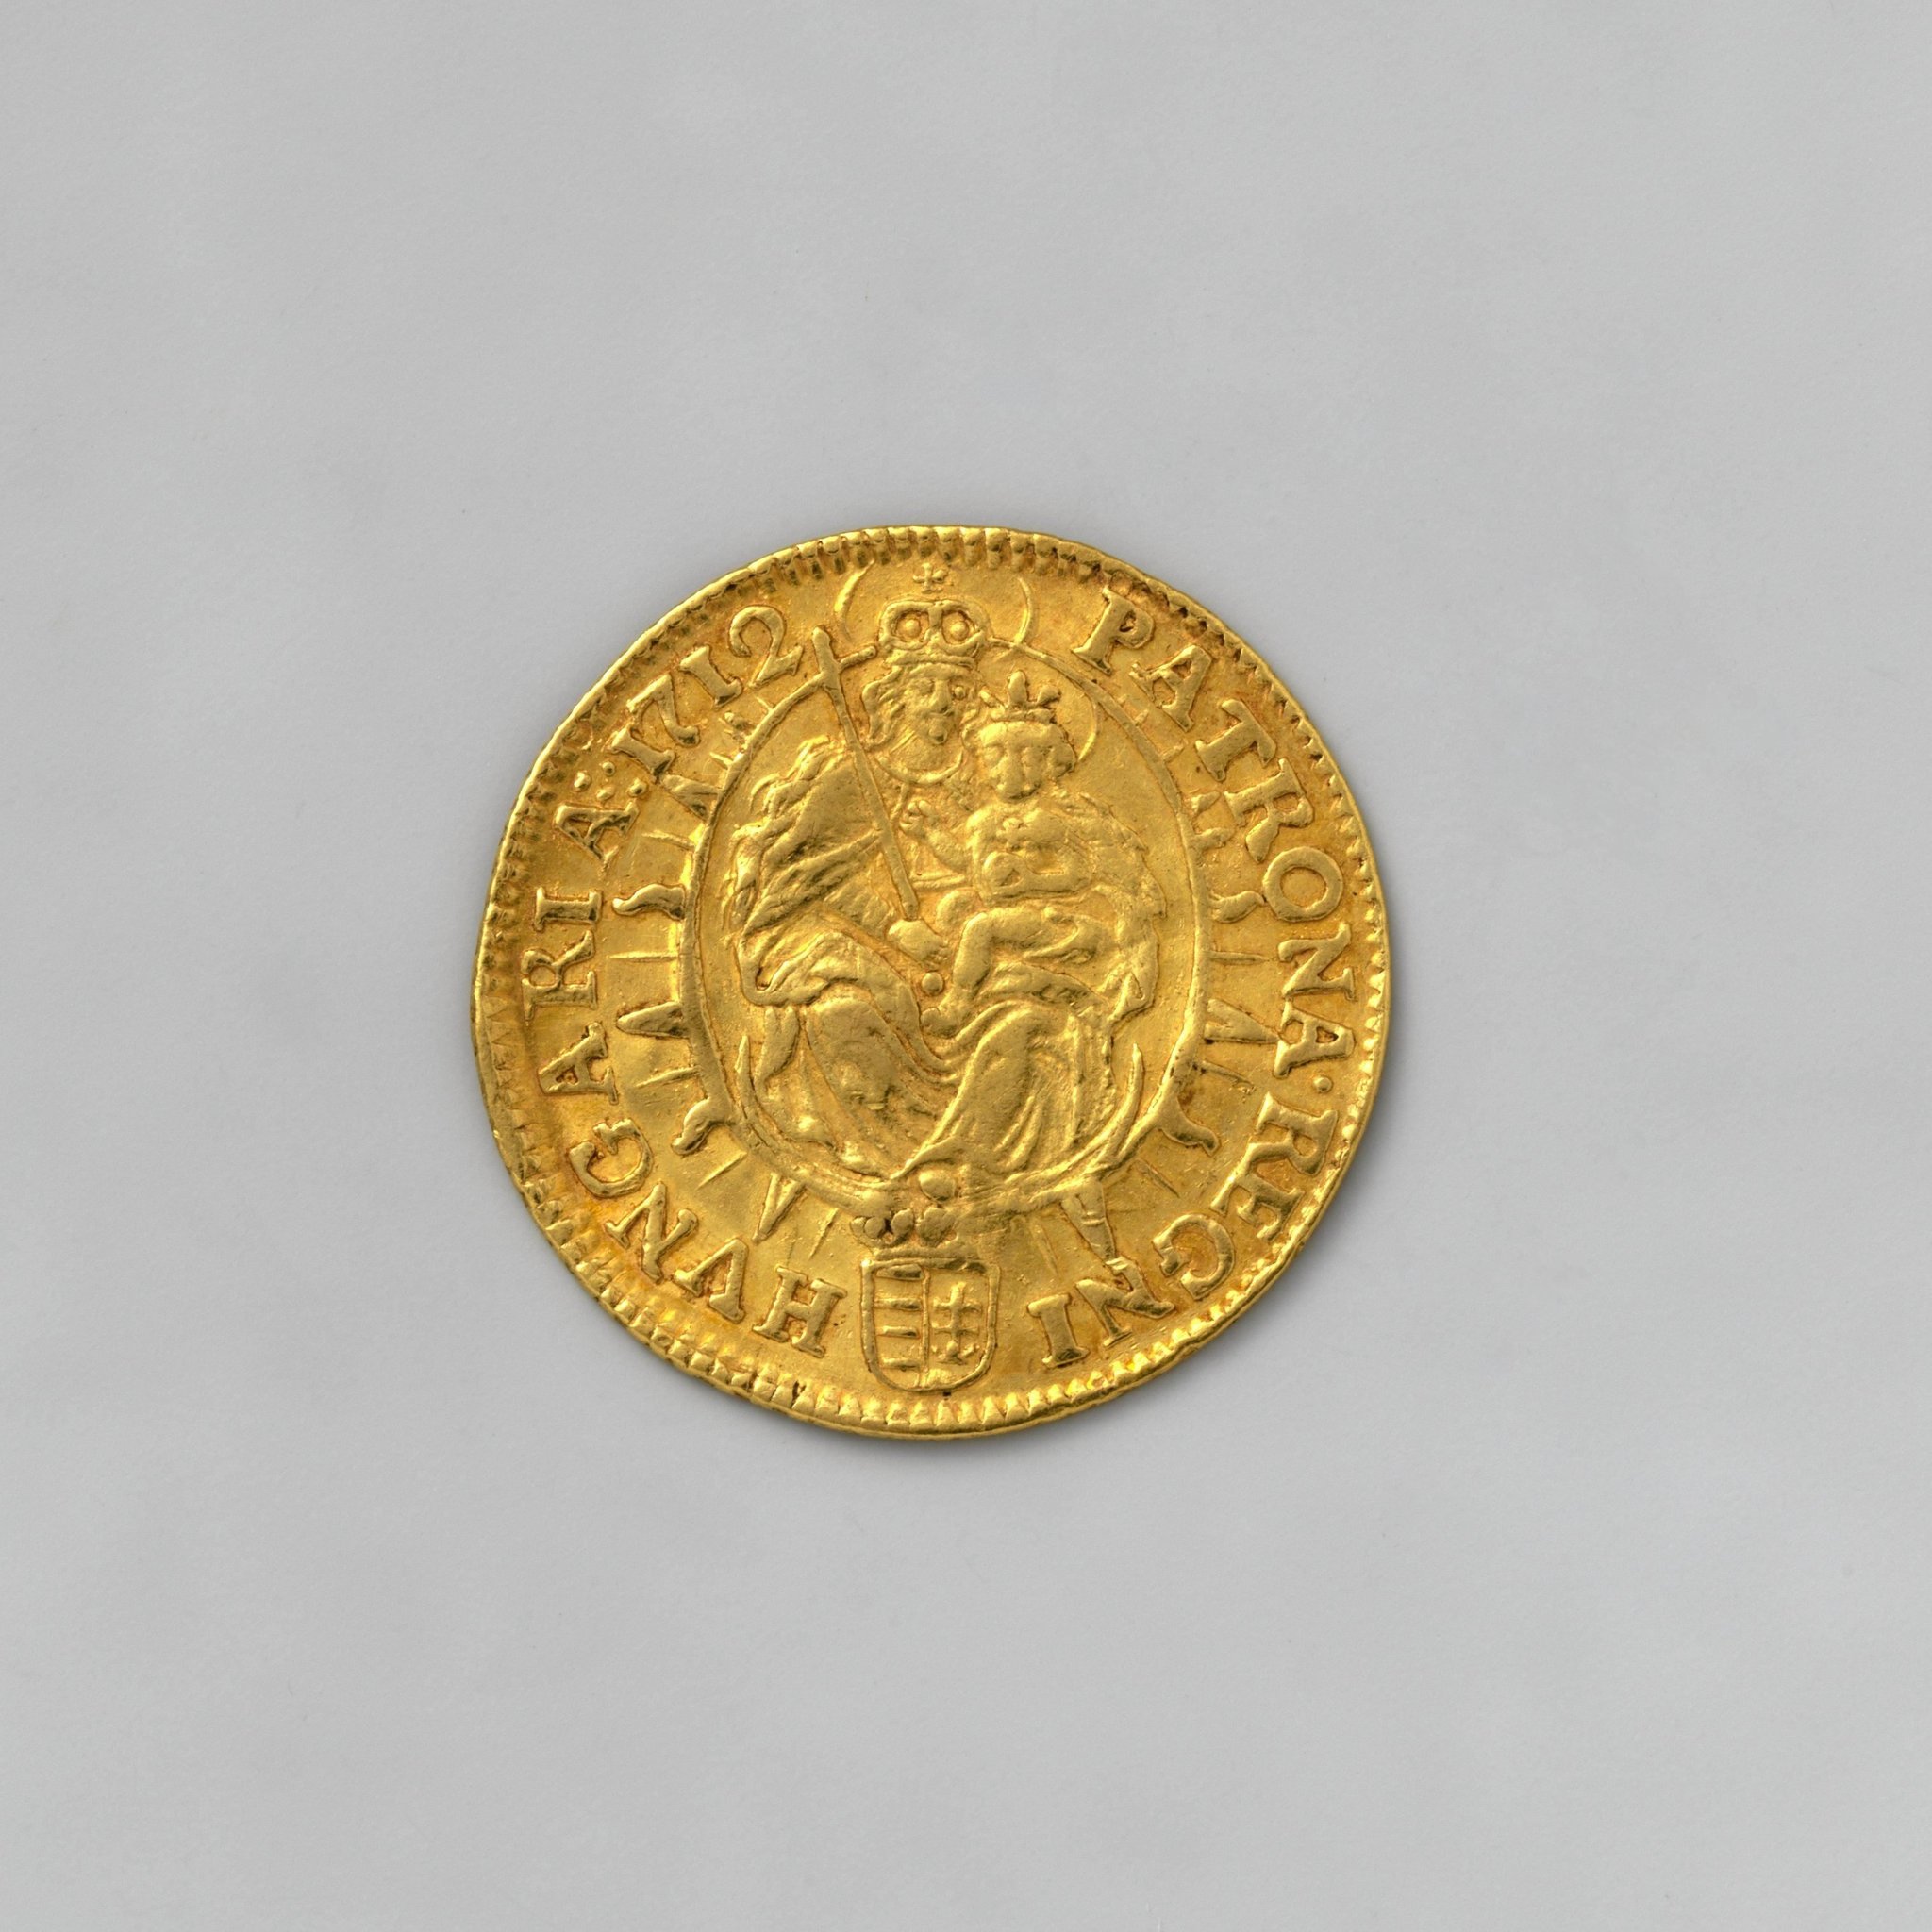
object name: ducat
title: Hongarije, keizer Karel VI, koning van Hongarije, dukaat, 1712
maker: Anonymous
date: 1712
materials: gold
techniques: striking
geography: kremnica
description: Gouden munt. Voorzijde: tussen letters K B [=Kremnitz] de gekroonde keizer, staande, naar rechts kijkend. Op zijn hoofd de keizerskroon, in zijn rechterhand het zwaard, in zijn linker de rijksappel. Keerzijde: binnen een stralenkrans de madonna met het kind, waaronder wapenschild van Hongarije. Jaartal bovenaan aan het eind van het omschrift. Kabelrand.